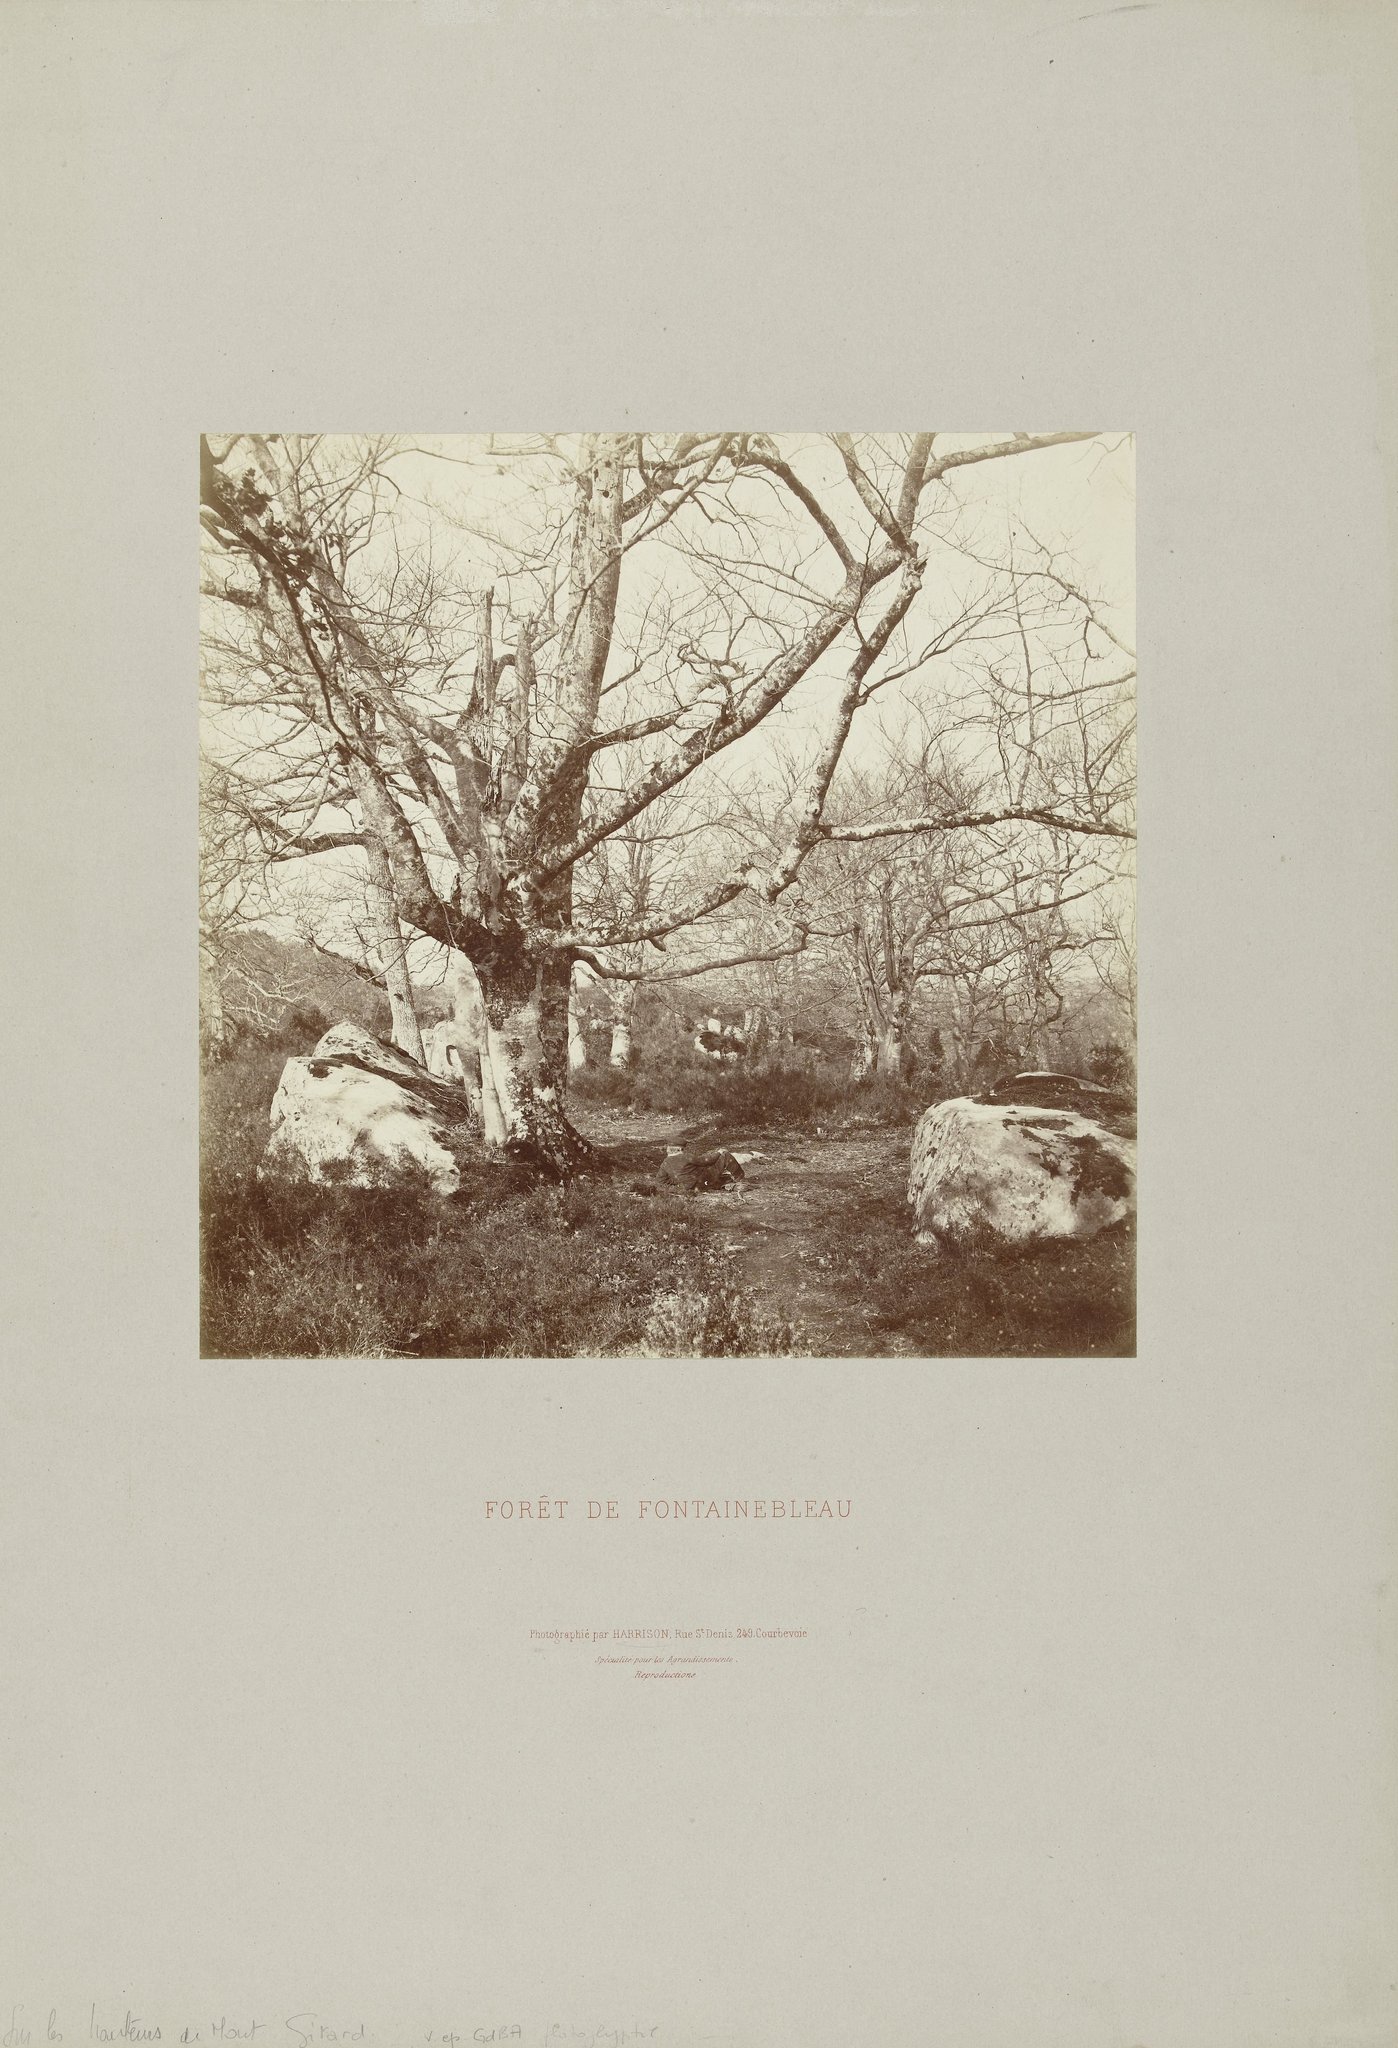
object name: photograph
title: Forêt de Fontainebleau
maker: william harrison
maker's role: fotograaf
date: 1870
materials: cardboard, paper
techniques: albumen print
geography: fontainebleau forest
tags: forest, wood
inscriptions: address: ‘Rue St Denis 249, Courbevoie’, inscription: ‘Spécialité pour les Agrandissements/ Reproductions’